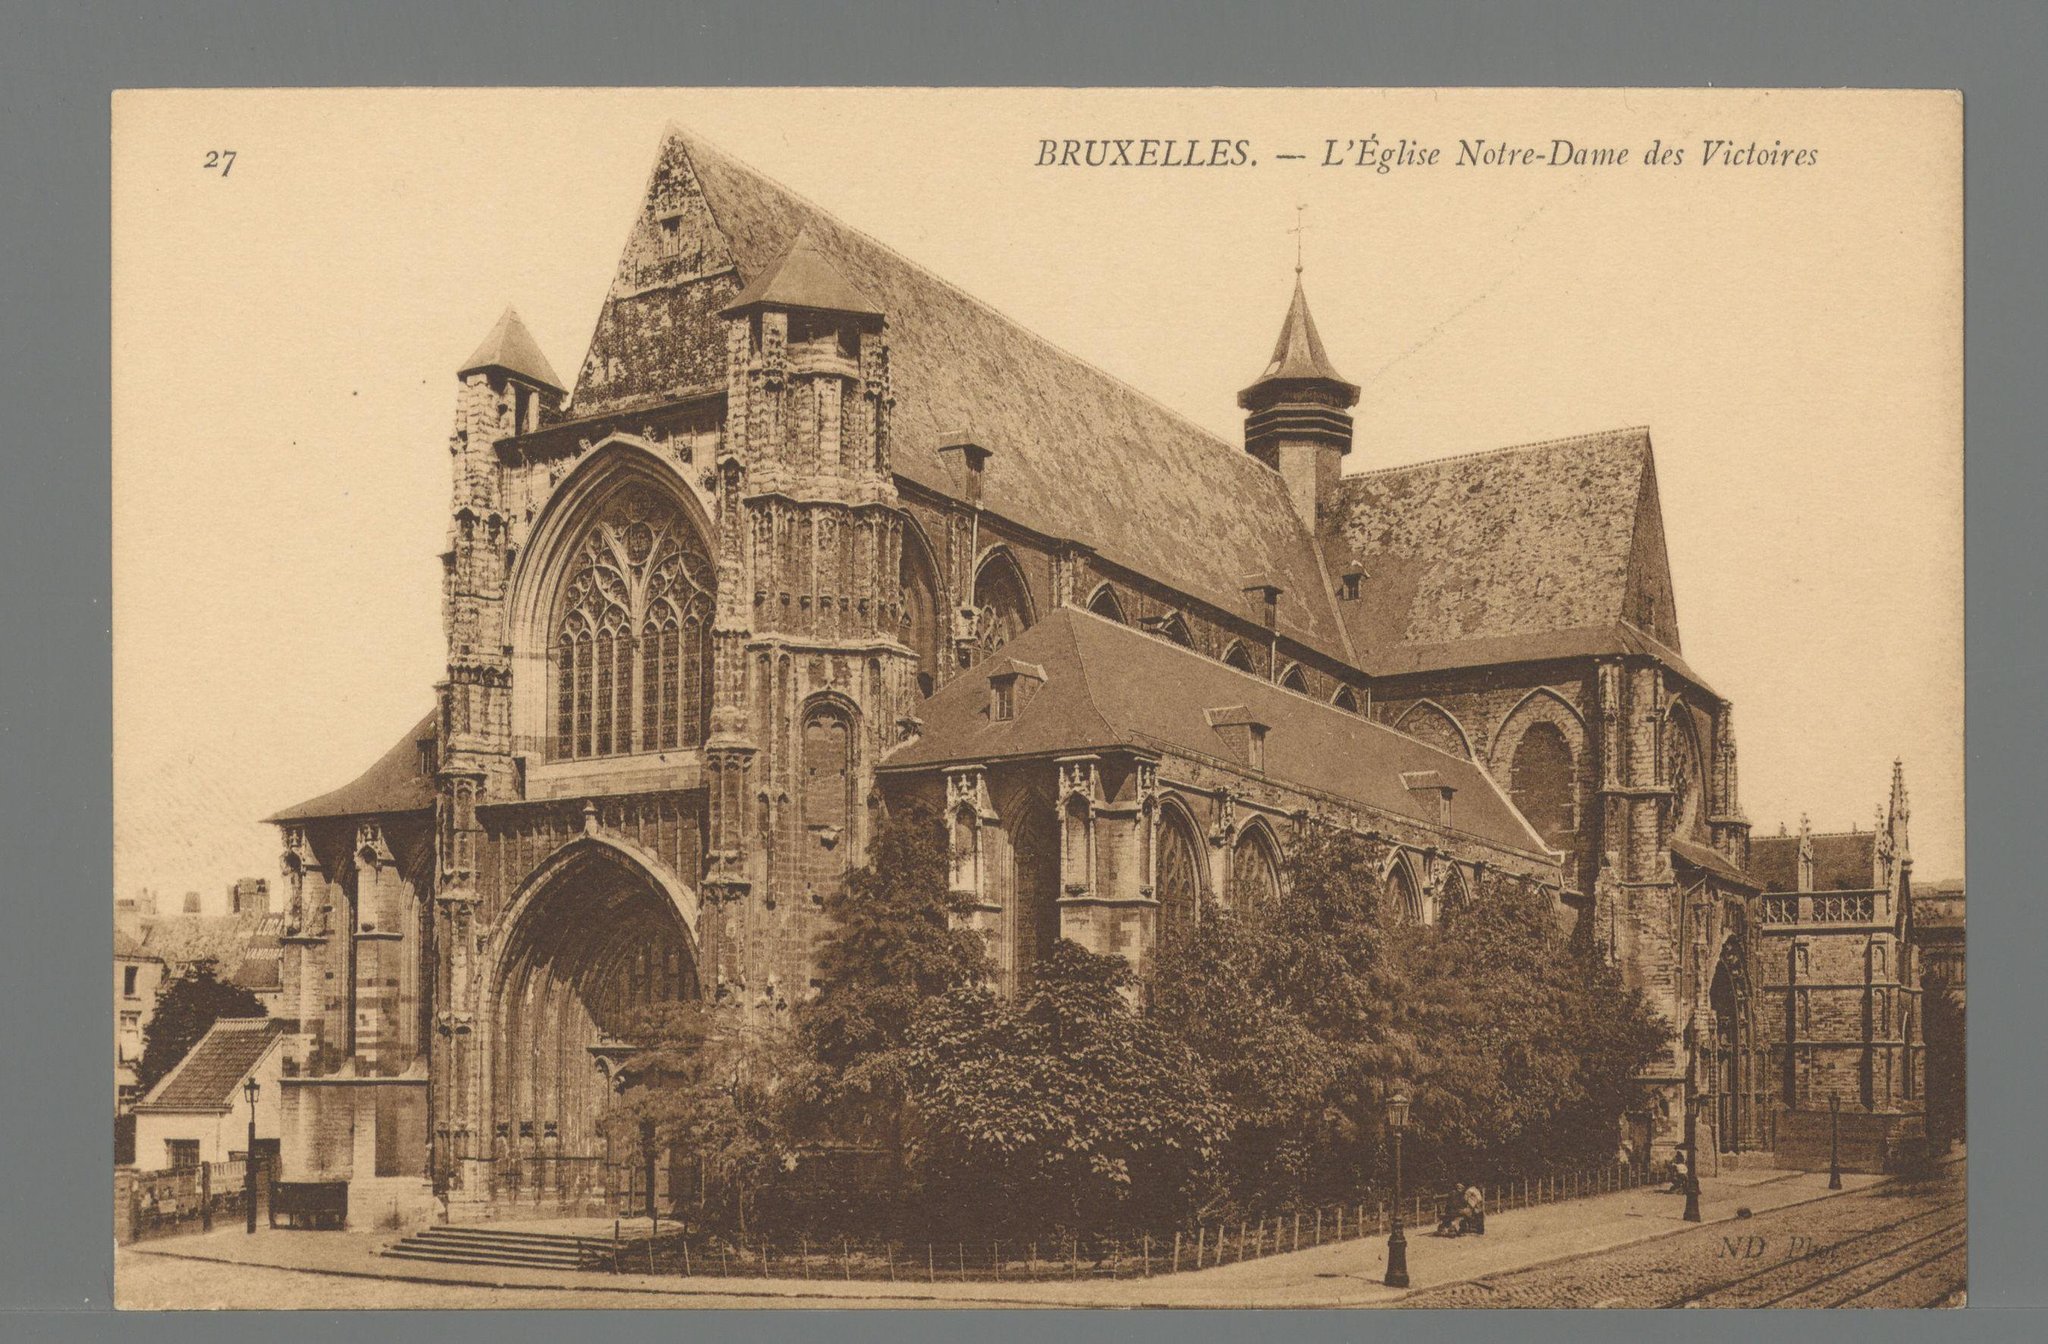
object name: photomechanical print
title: Bruxelles. L'Église Notre-Dame des Victoires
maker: Anonymous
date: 1906-1918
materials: cardboard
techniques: photograph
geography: paris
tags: church (exterior)